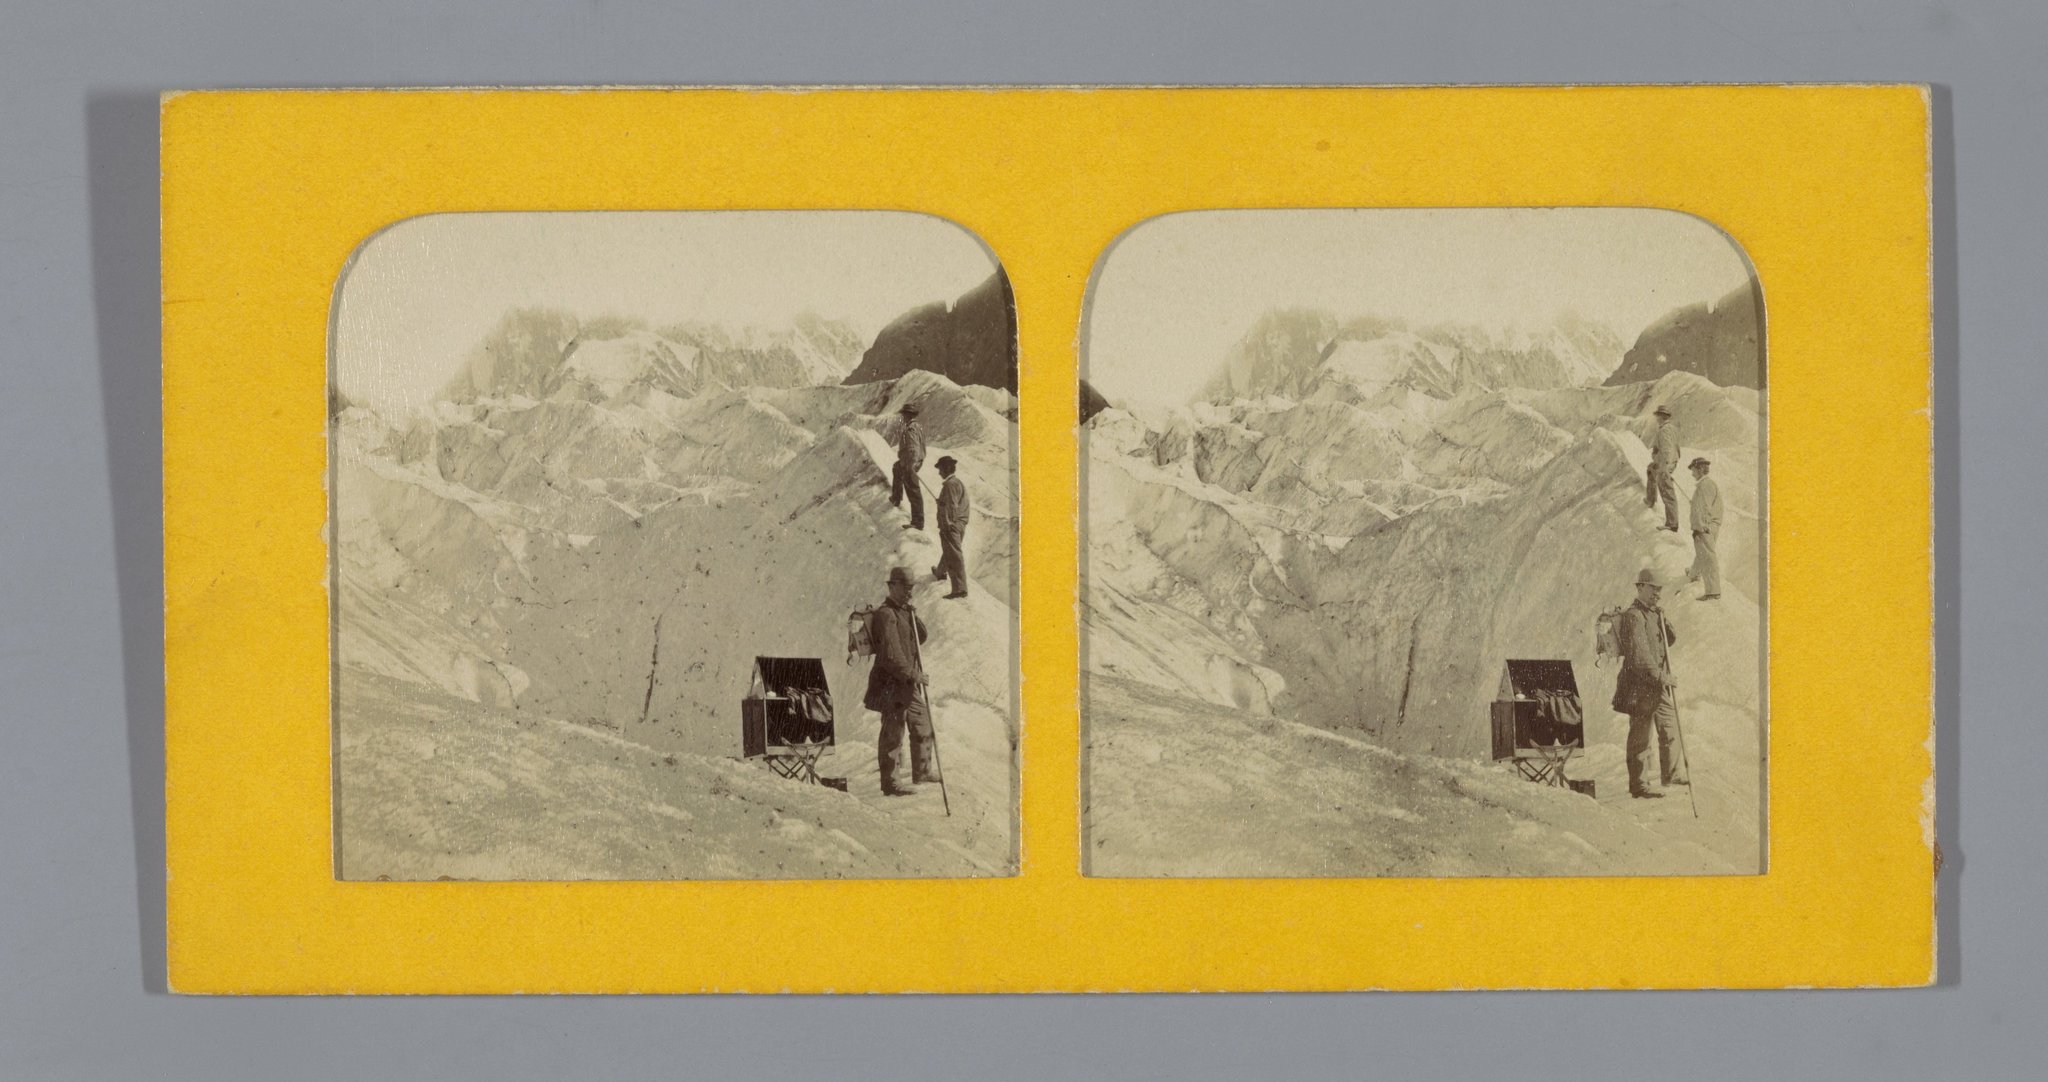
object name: tissue stereograph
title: Bergbeklimmers op de Bossonsgletsjer nabij het Mont Blanc-massief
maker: Anonymous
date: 1855-1875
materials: cardboard, paper, photographic support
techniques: albumen print, hand coloring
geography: haute-savoie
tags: mountain climbing, mountaineering, glacier, bossons glacier